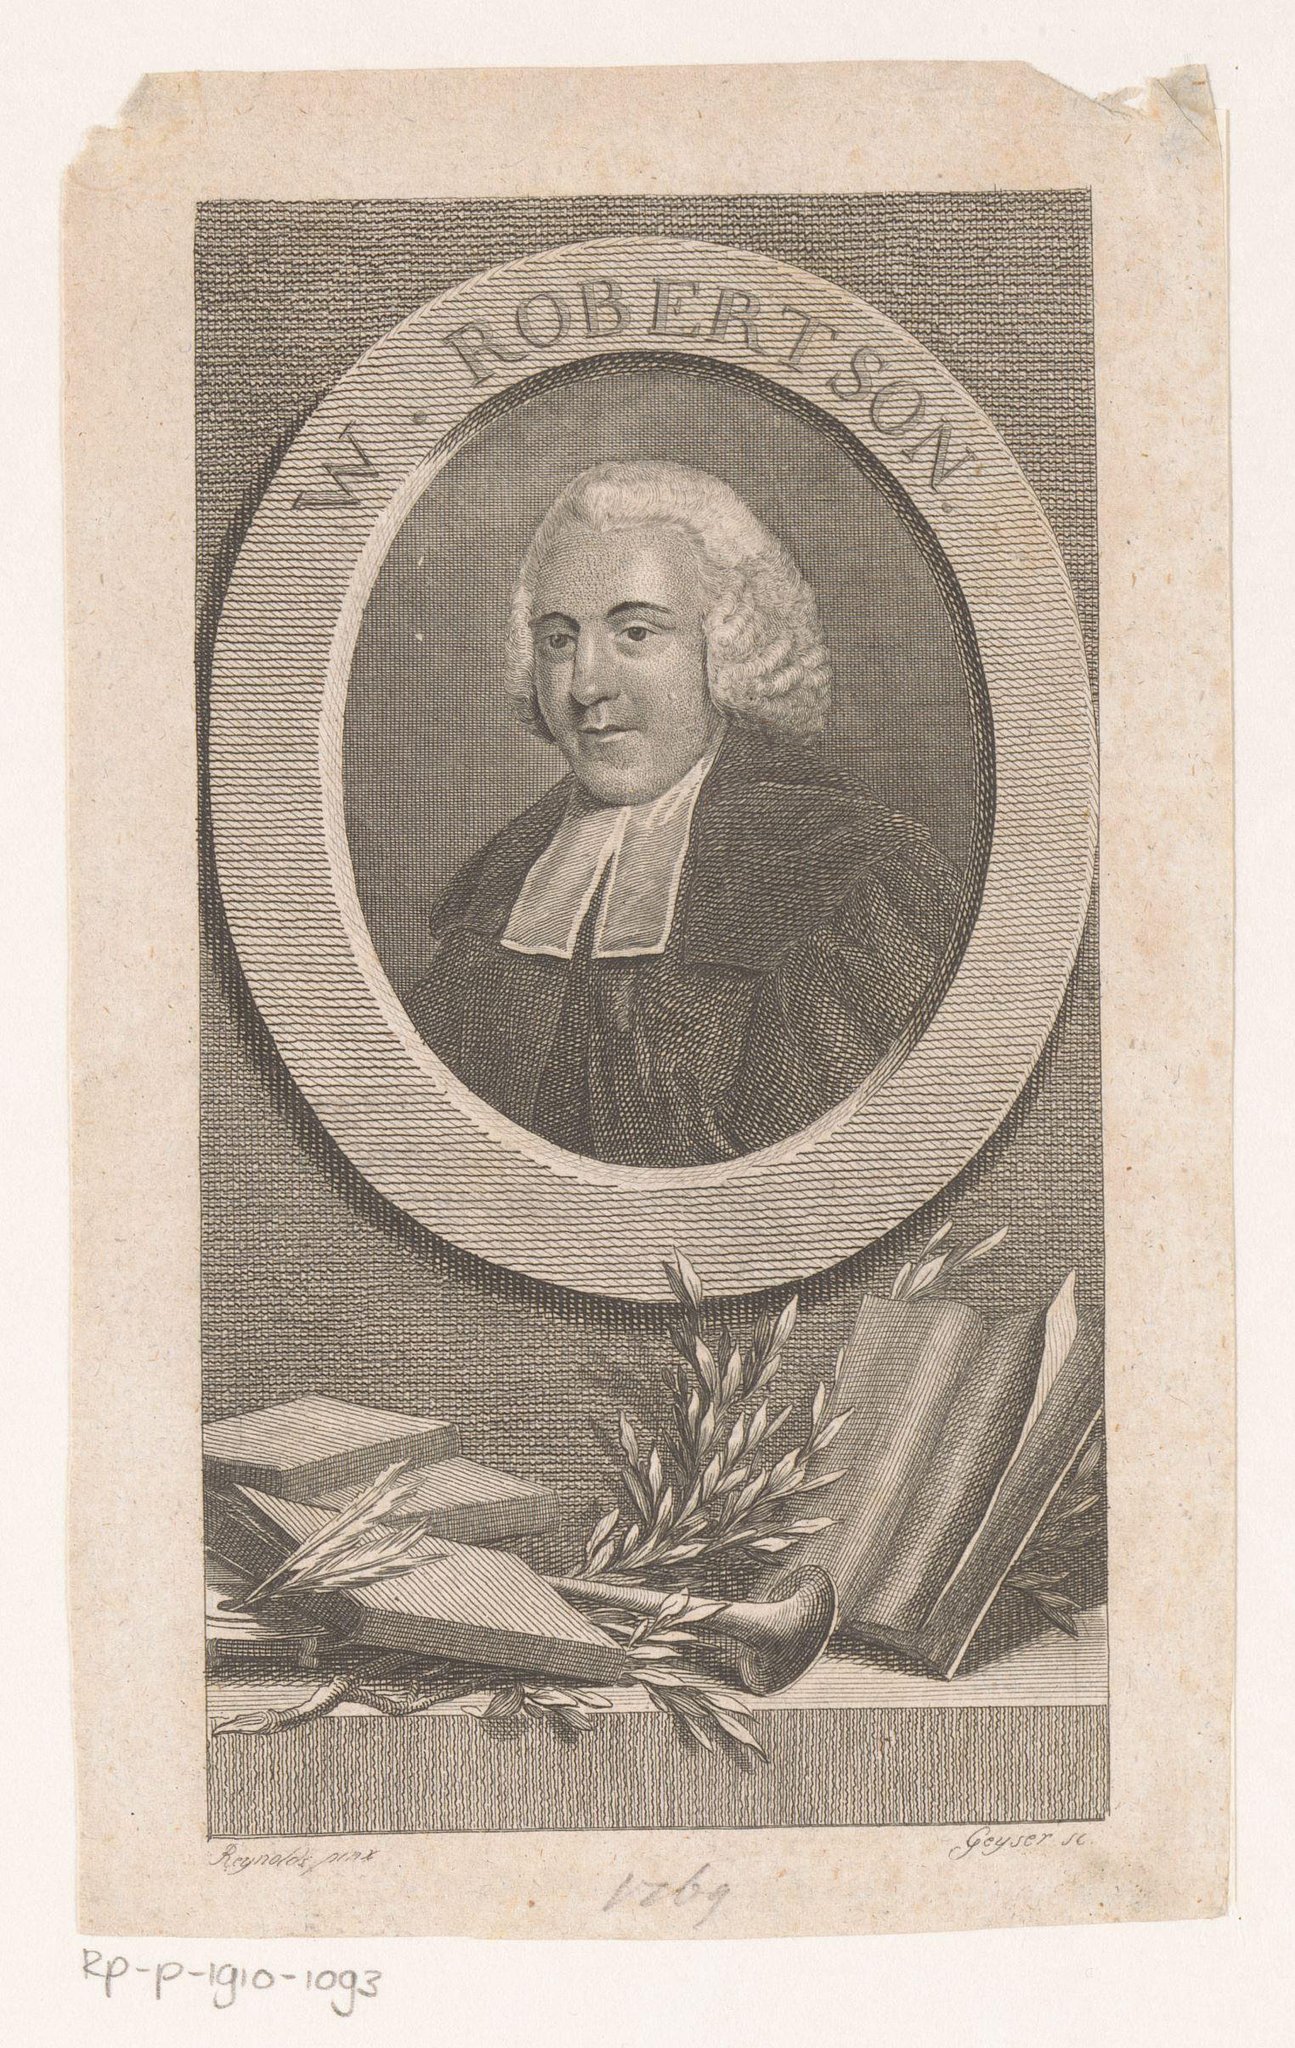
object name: print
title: Portret van William Robertson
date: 1752-1803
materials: paper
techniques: engraving, etching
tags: trees: laurel (branch, stick), history, horn, trumpet, cornet, trombone, tuba, historical persons, book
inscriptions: collector's mark: Lugt 2228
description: Prent gebruikt voor: Robertson, William. Geschichte von Amerika. Leipzig: s.n., 1777.